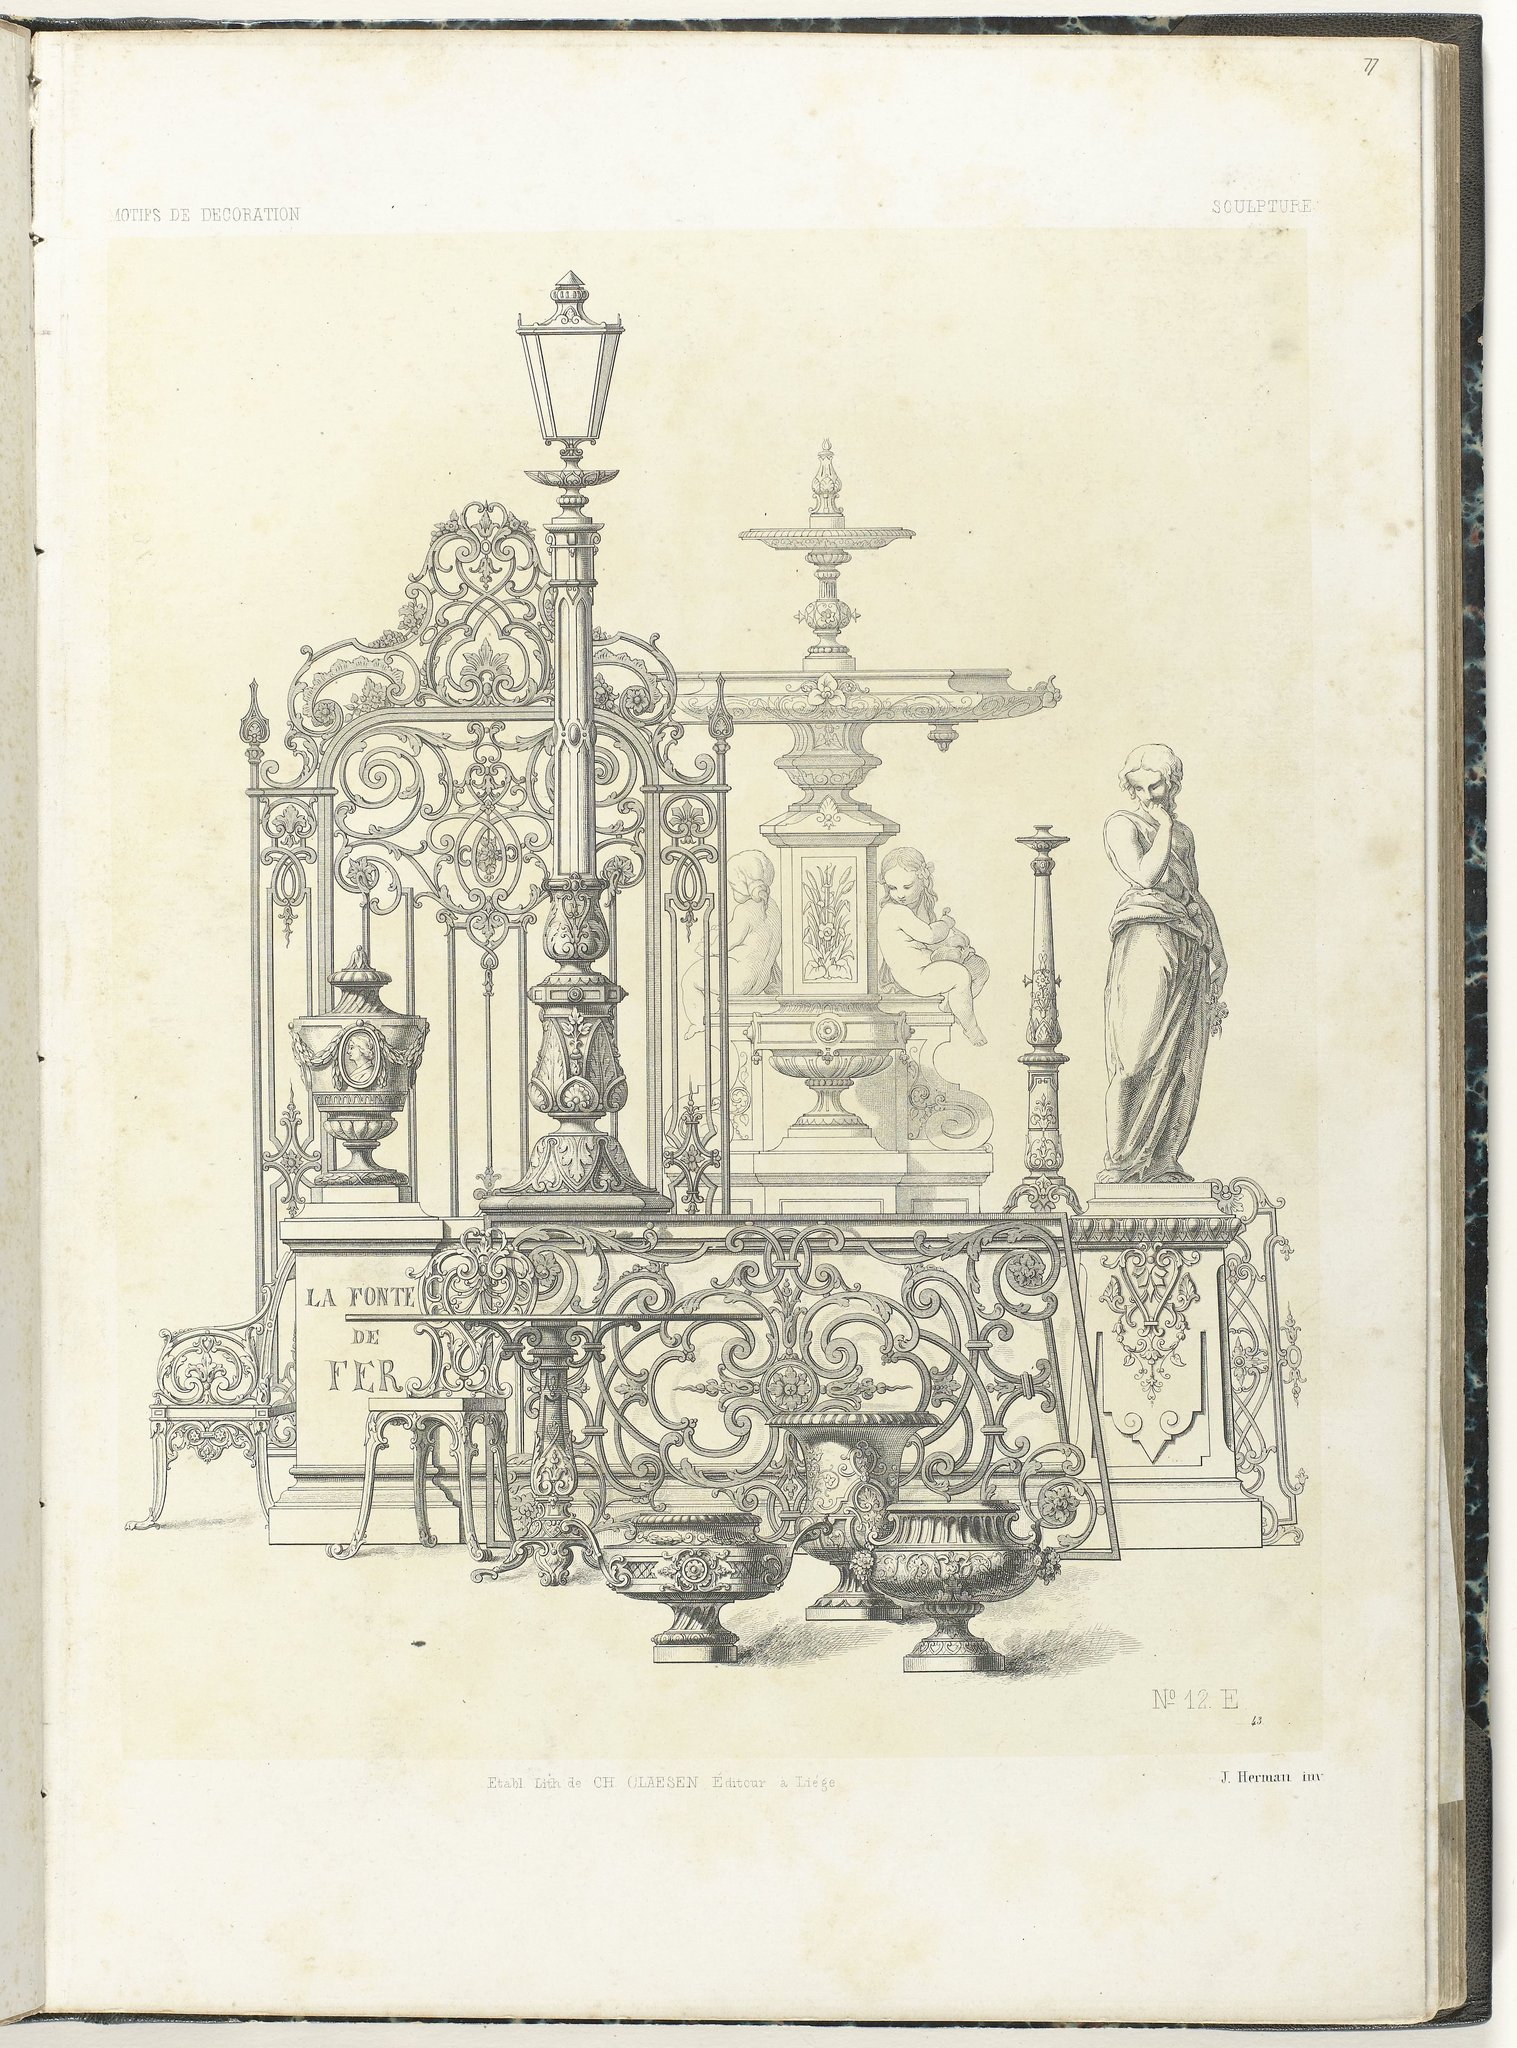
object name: print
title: Objecten van gietijzer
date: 1866-1900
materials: paper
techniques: tone lithography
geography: liège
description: Verschillende objecten van ijzer waaronder hekken, vazen, kaarsenstandaards en een beeld. Achteraan is een fontein afgebeeld. Linksboven staat vermeld: Motifs de Decoration, rechtsboven: Sculpture, rechtsonder: N° 12.E. 43.